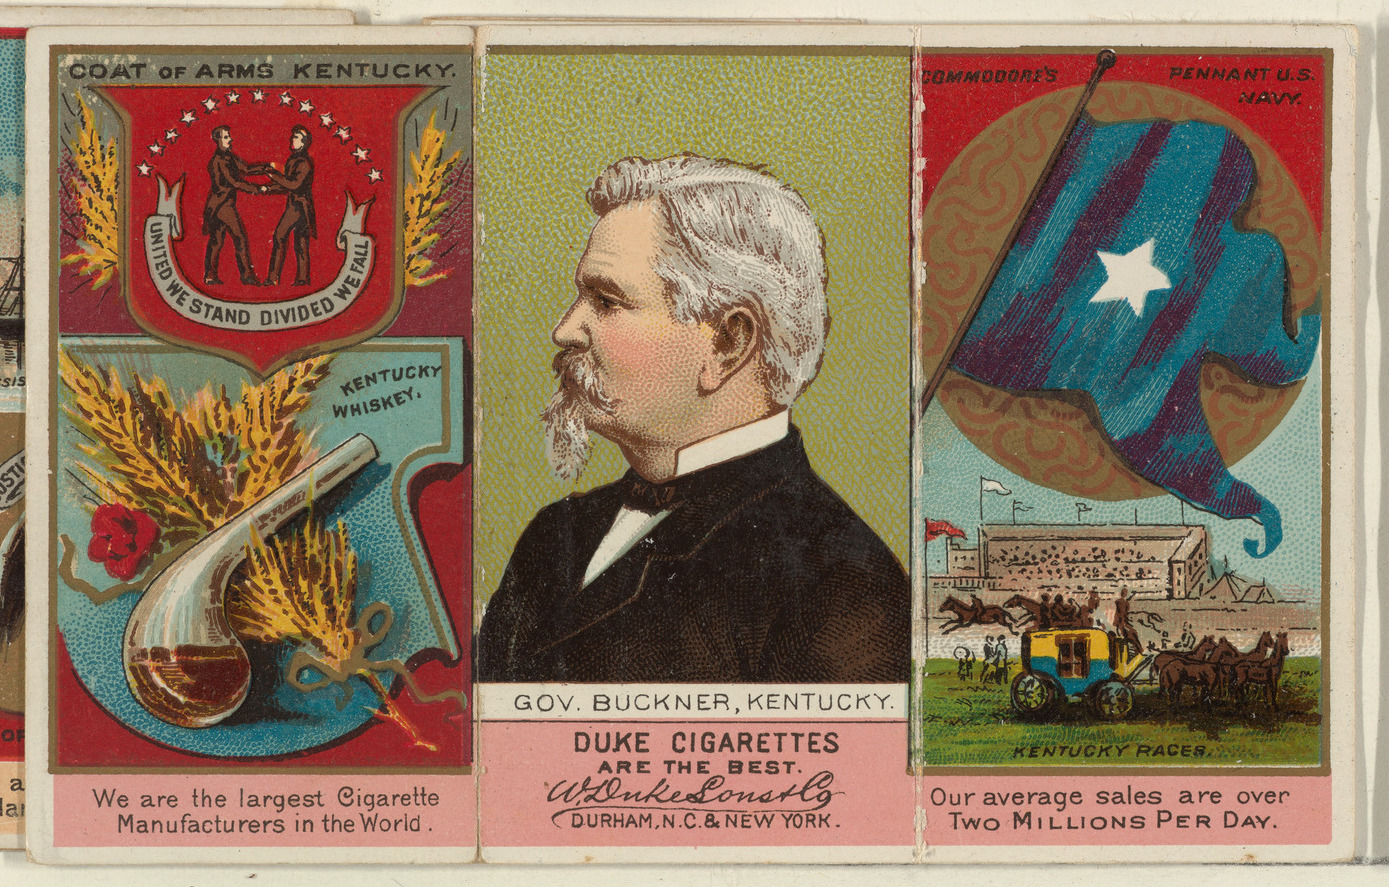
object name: print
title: Governor Buckner, Kentucky, from "Governors, Arms, Etc." series (N133-2), issued by Duke Sons & Co.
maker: w. duke, sons & co.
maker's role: publisher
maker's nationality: american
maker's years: 1870-1920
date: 1888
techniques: color lithograph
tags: men,profiles,coat of arms,flags,carriages